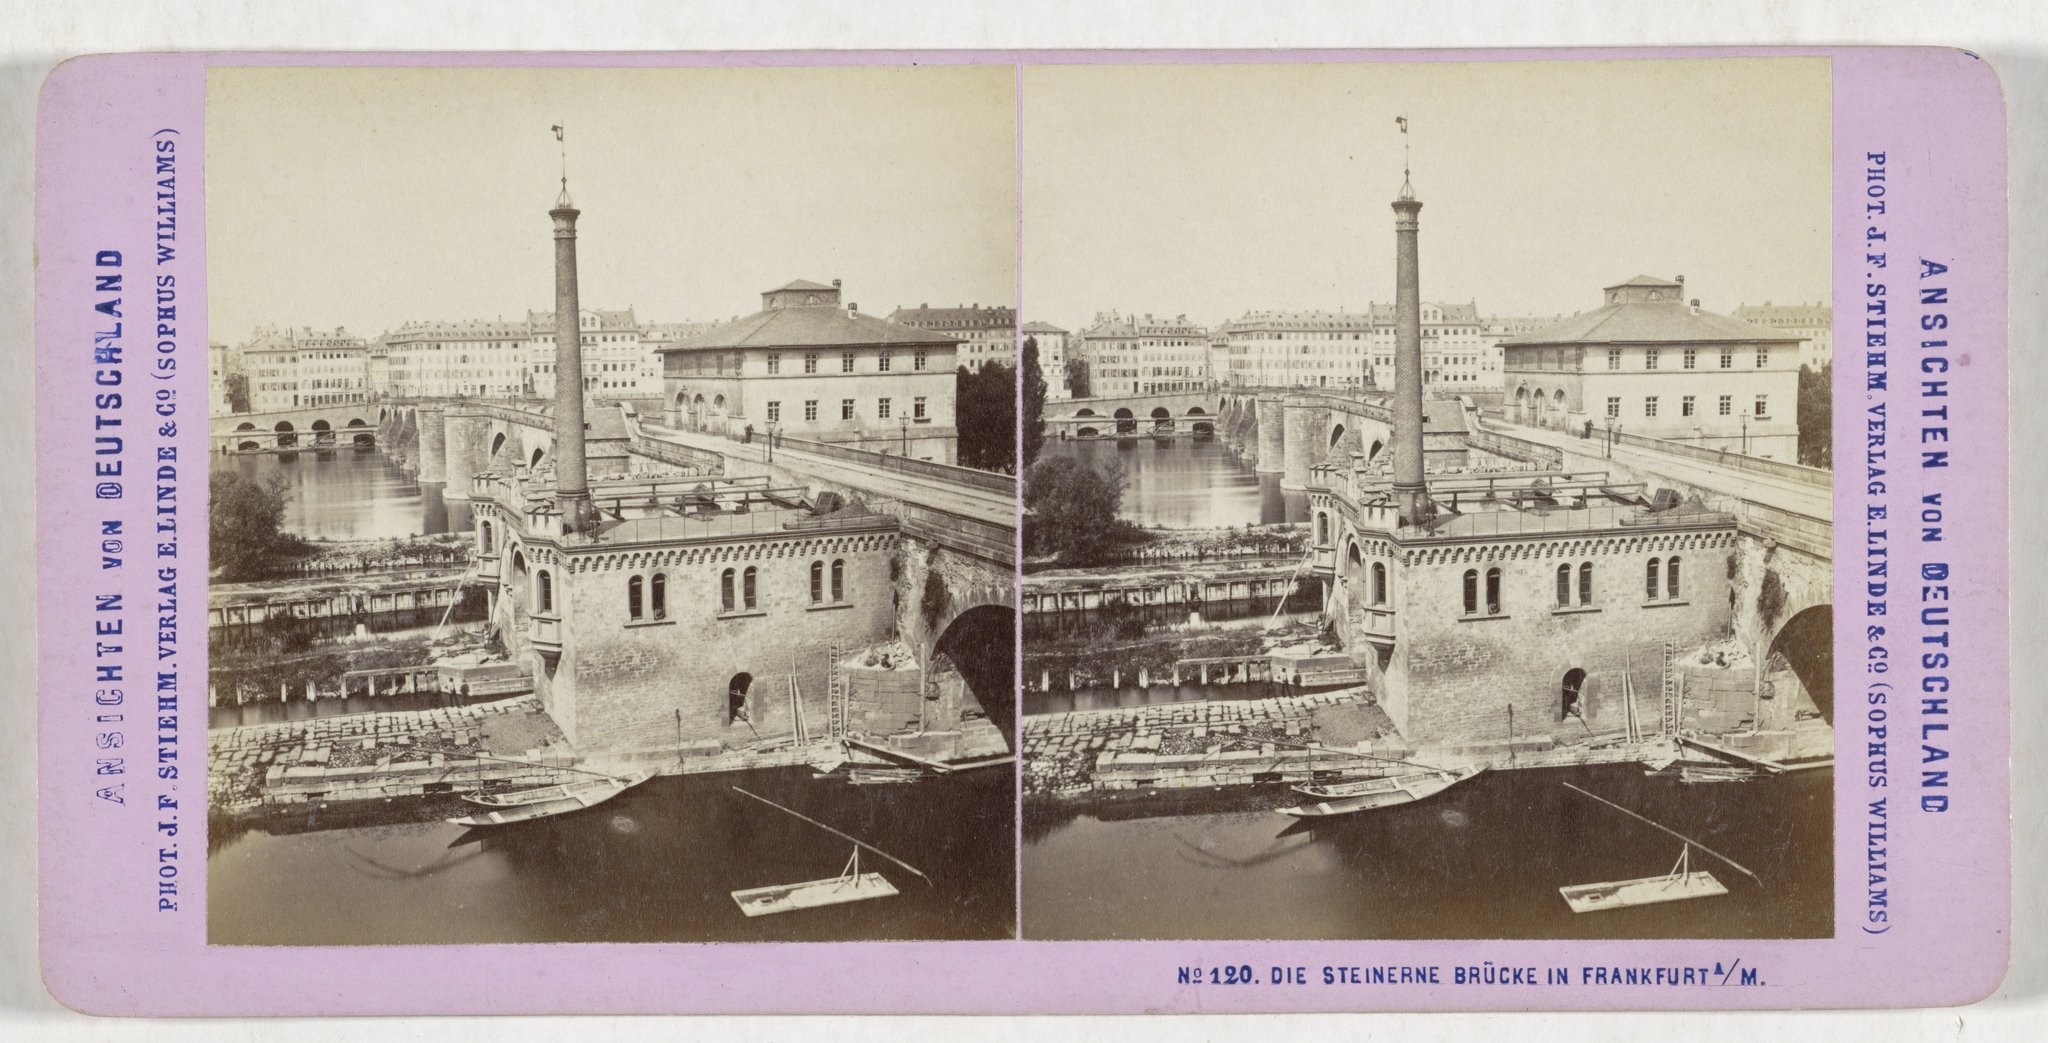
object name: stereograph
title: Alte Brücke in Frankfurt am Main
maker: johann friedrich stiehm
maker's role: fotograaf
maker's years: 1826-1902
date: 1869-1872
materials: cardboard, paper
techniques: albumen print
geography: frankfurt am main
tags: bridge with structure, i.e. cover or buildings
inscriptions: number: ‘No 120.’